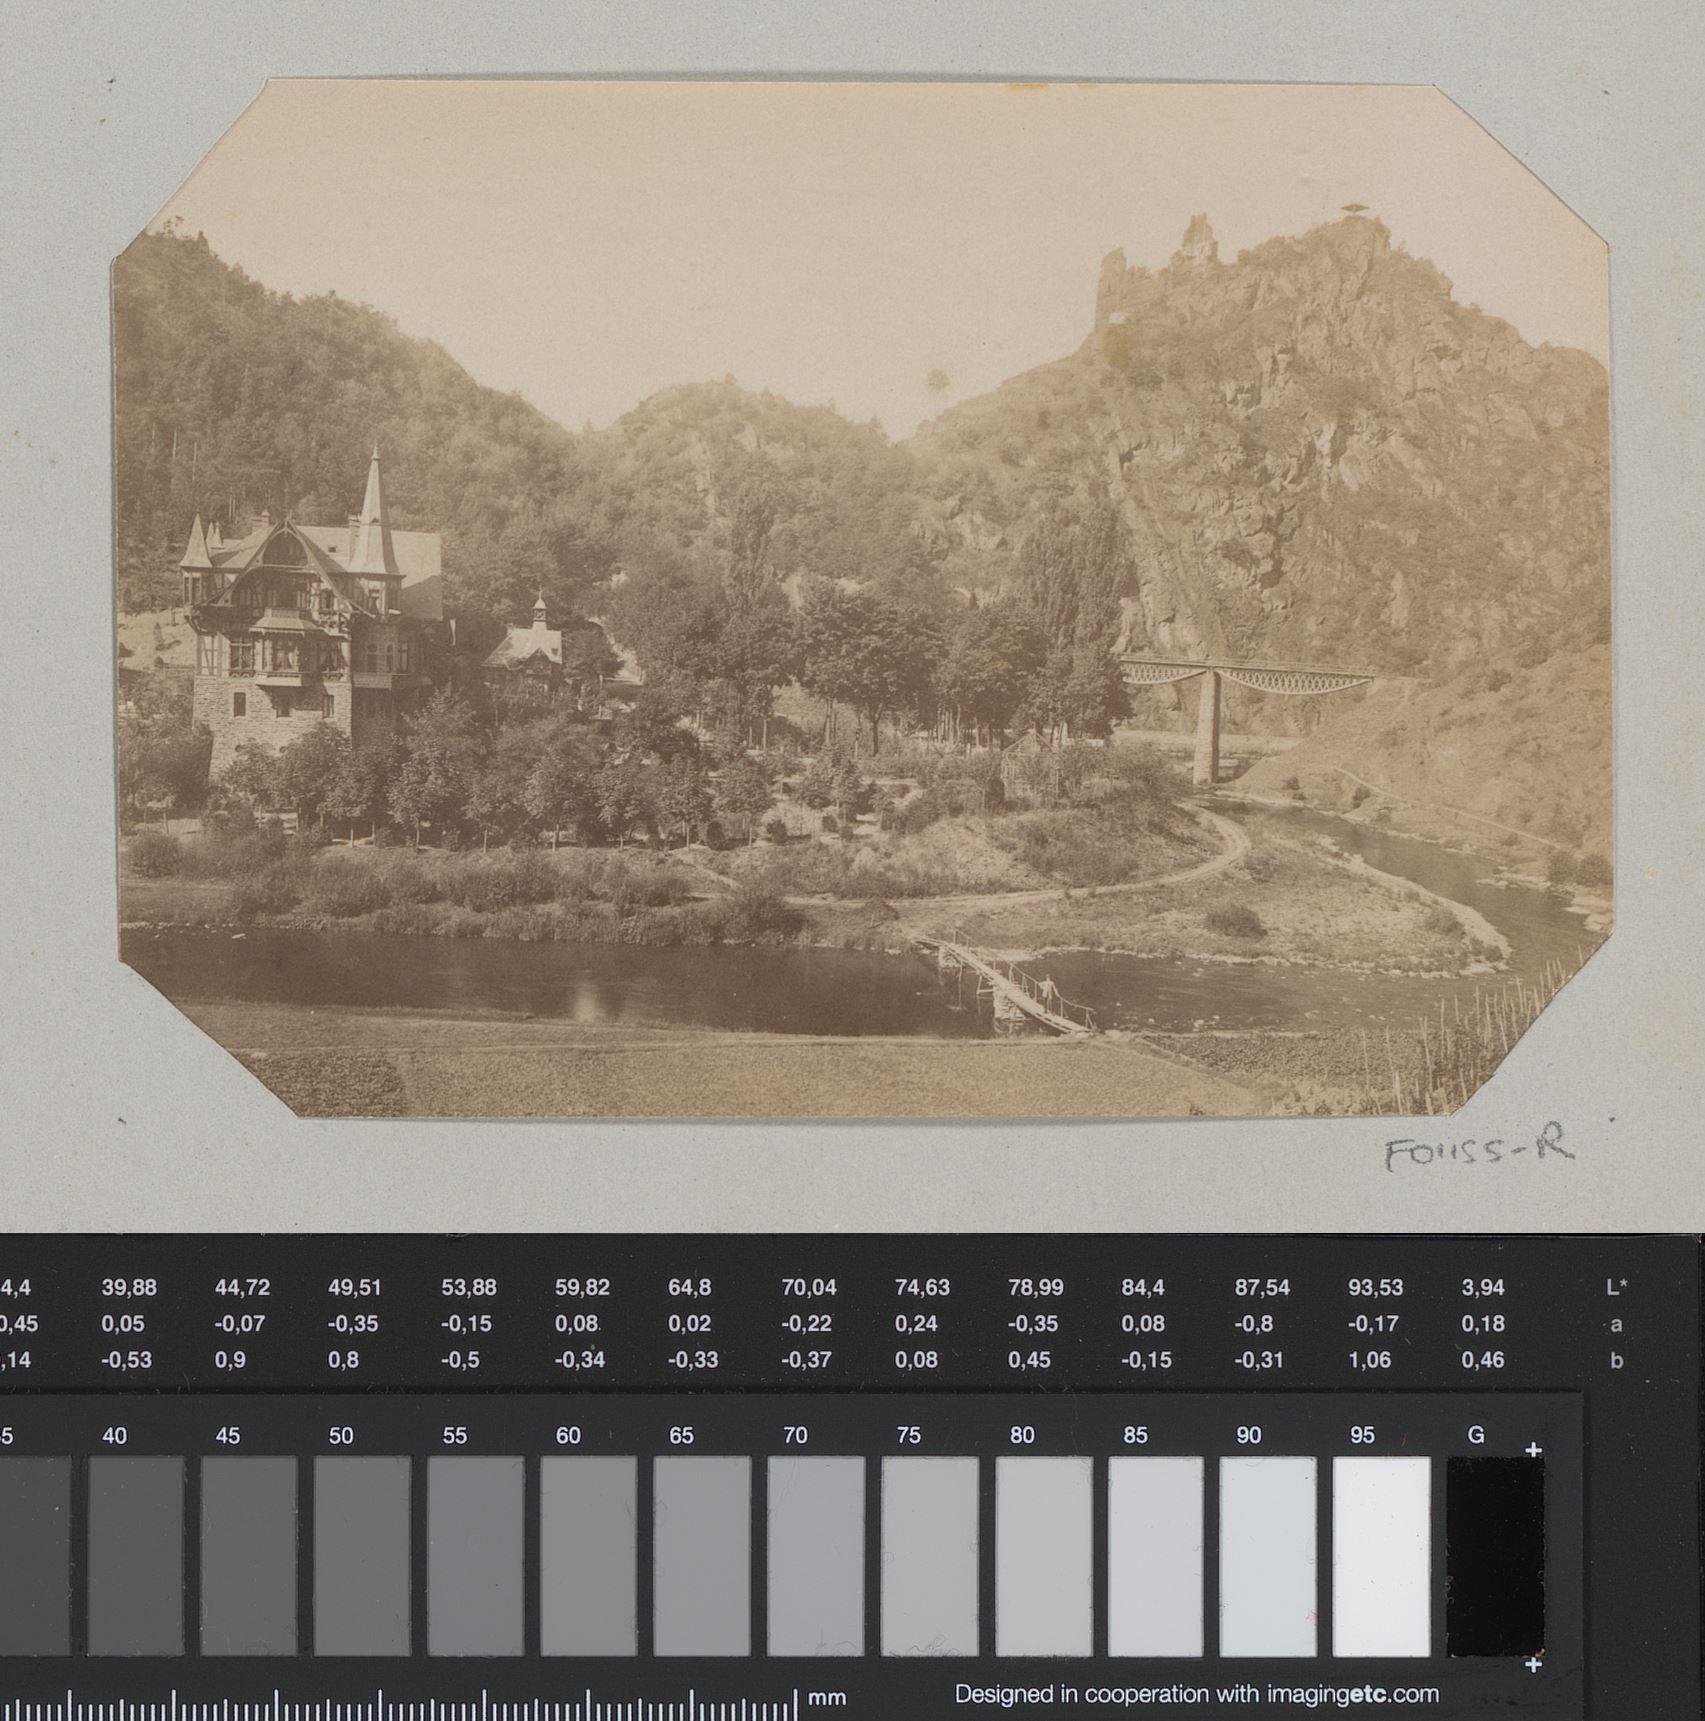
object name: photograph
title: Landschap met bergen en rivier te Altenahr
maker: anselm schmitz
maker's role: publisher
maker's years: 1831-1903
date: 1896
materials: photographic support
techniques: albumen print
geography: altenahr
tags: river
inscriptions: date